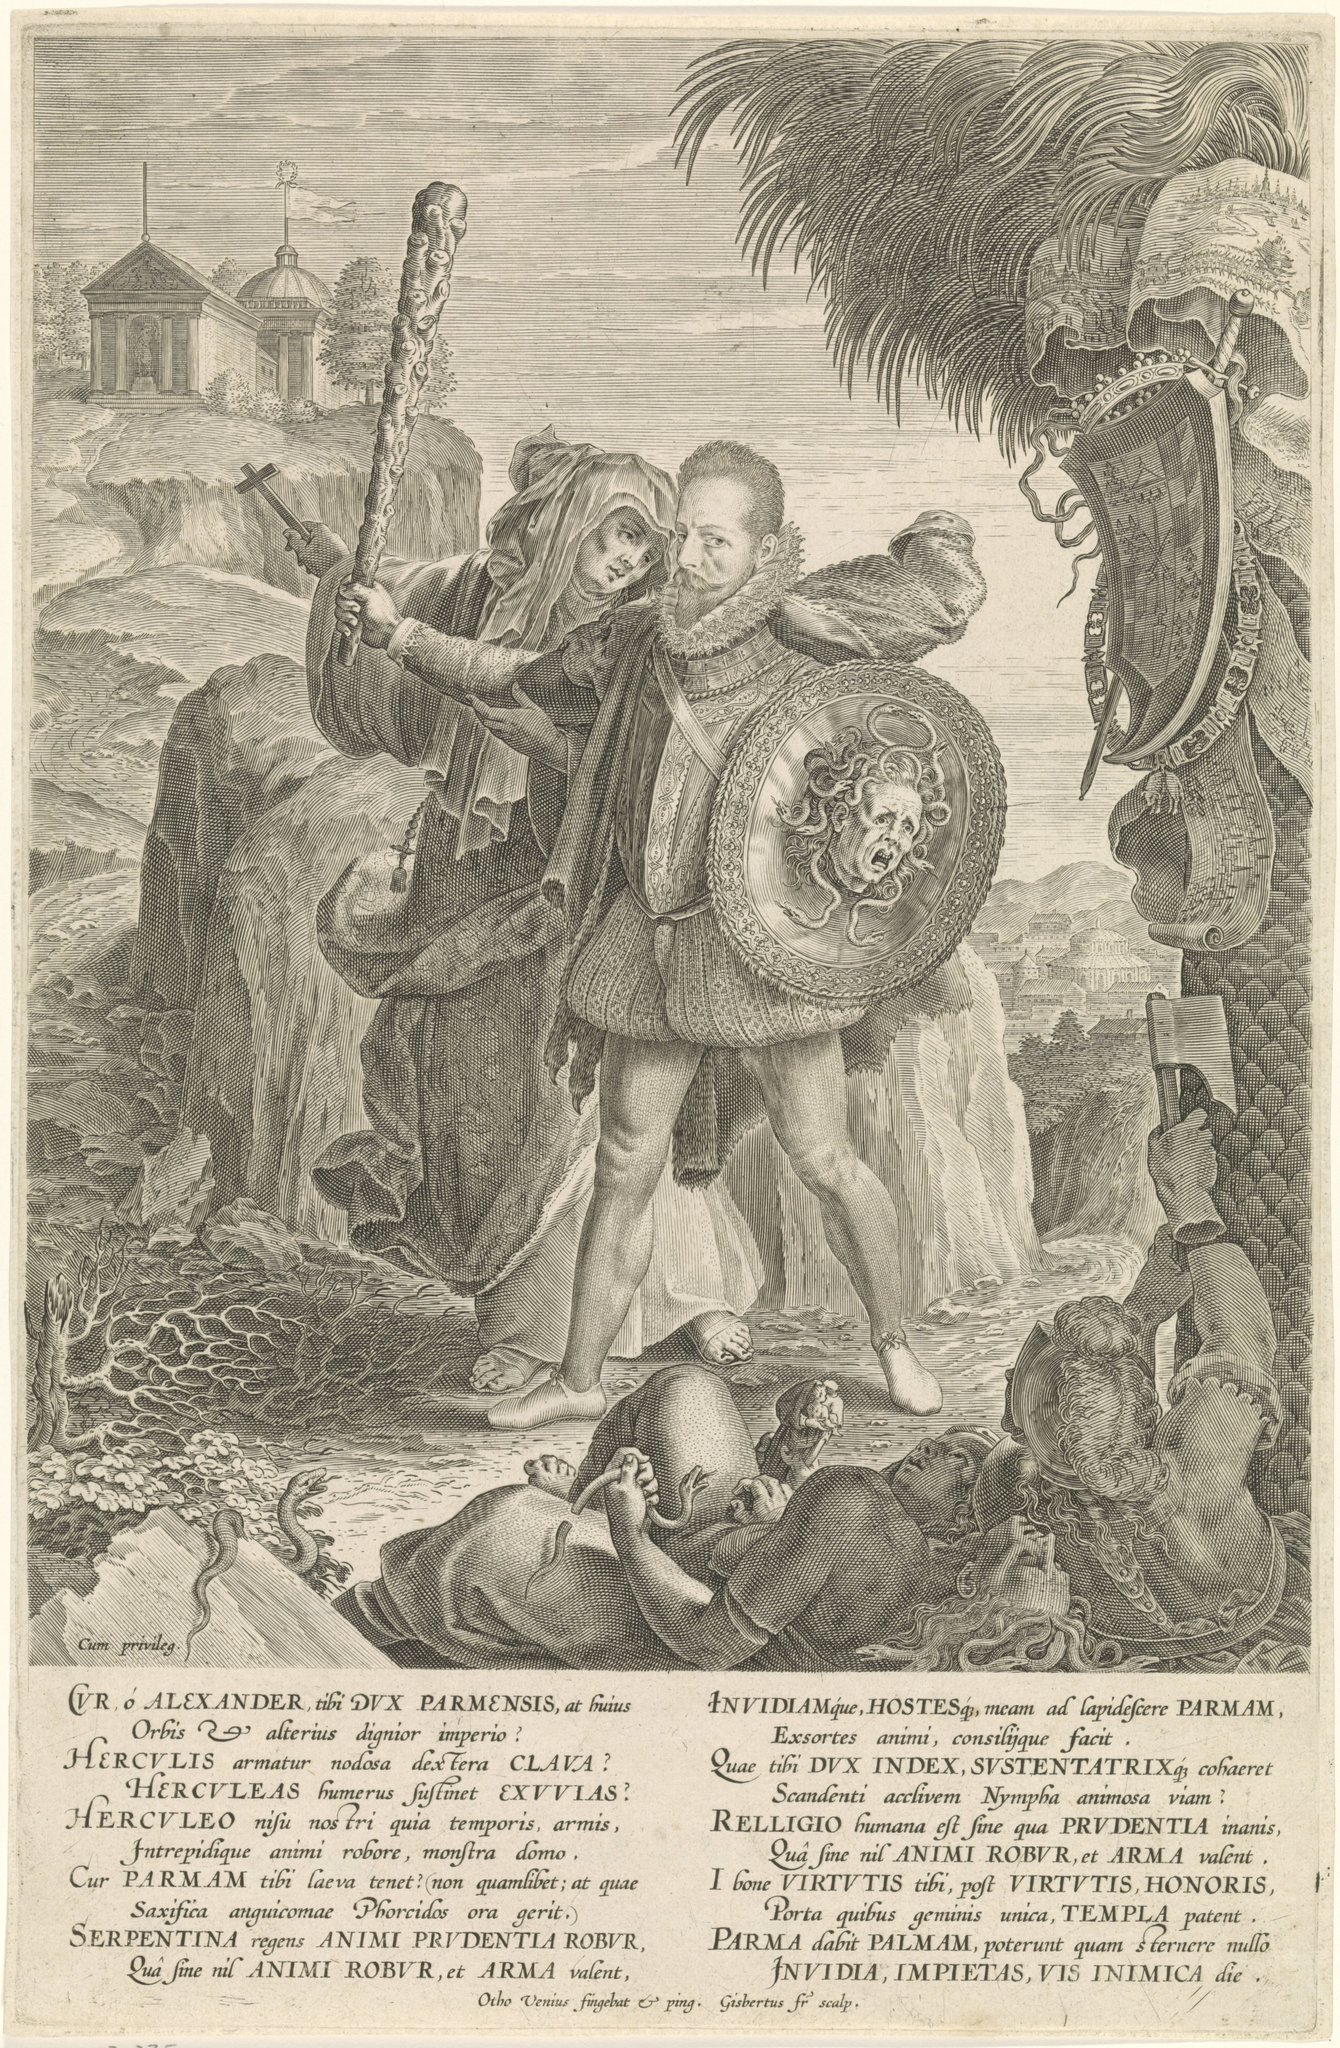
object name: print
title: Allegorisch portret van Alessandro Farnese, hertog van Parma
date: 1585-1628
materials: paper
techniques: engraving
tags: rome, alessandro farnese (landvoogd van de nederlanden en hertog van parma en piacenza), virtues of the ruler, envy; 'invidia' (ripa) ~ personification of one of the seven deadly sins, attributes of hercules, the church personified, 'ecclesia', usually with chalice and banner, attributes of medusa, beeldenstorm (1566)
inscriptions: collector's mark: Lugt 2228, collector's mark: Lugt 2760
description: Allegorie met Alessandro Farnese, de hertog van Parma, als voorvechter van de katholieke kerk in de Nederlanden, 1585. Parma als Hercules met knots en schild wordt door de personificatie van (Katholieke) Godsdienst naar de tempel van de deugd op een rots gewezen. Voor hem liggen verslagen op de grond Afgunst (Invidia), Onvroomheid (Impietas) met een kapot heiligenbeeld en Vijandige Kracht (Vis Inimica). Aan de palmboom rechts hangen het wapen van Parma en afbeeldingen van het beleg van Antwerpen en de schipbrug in 1585.